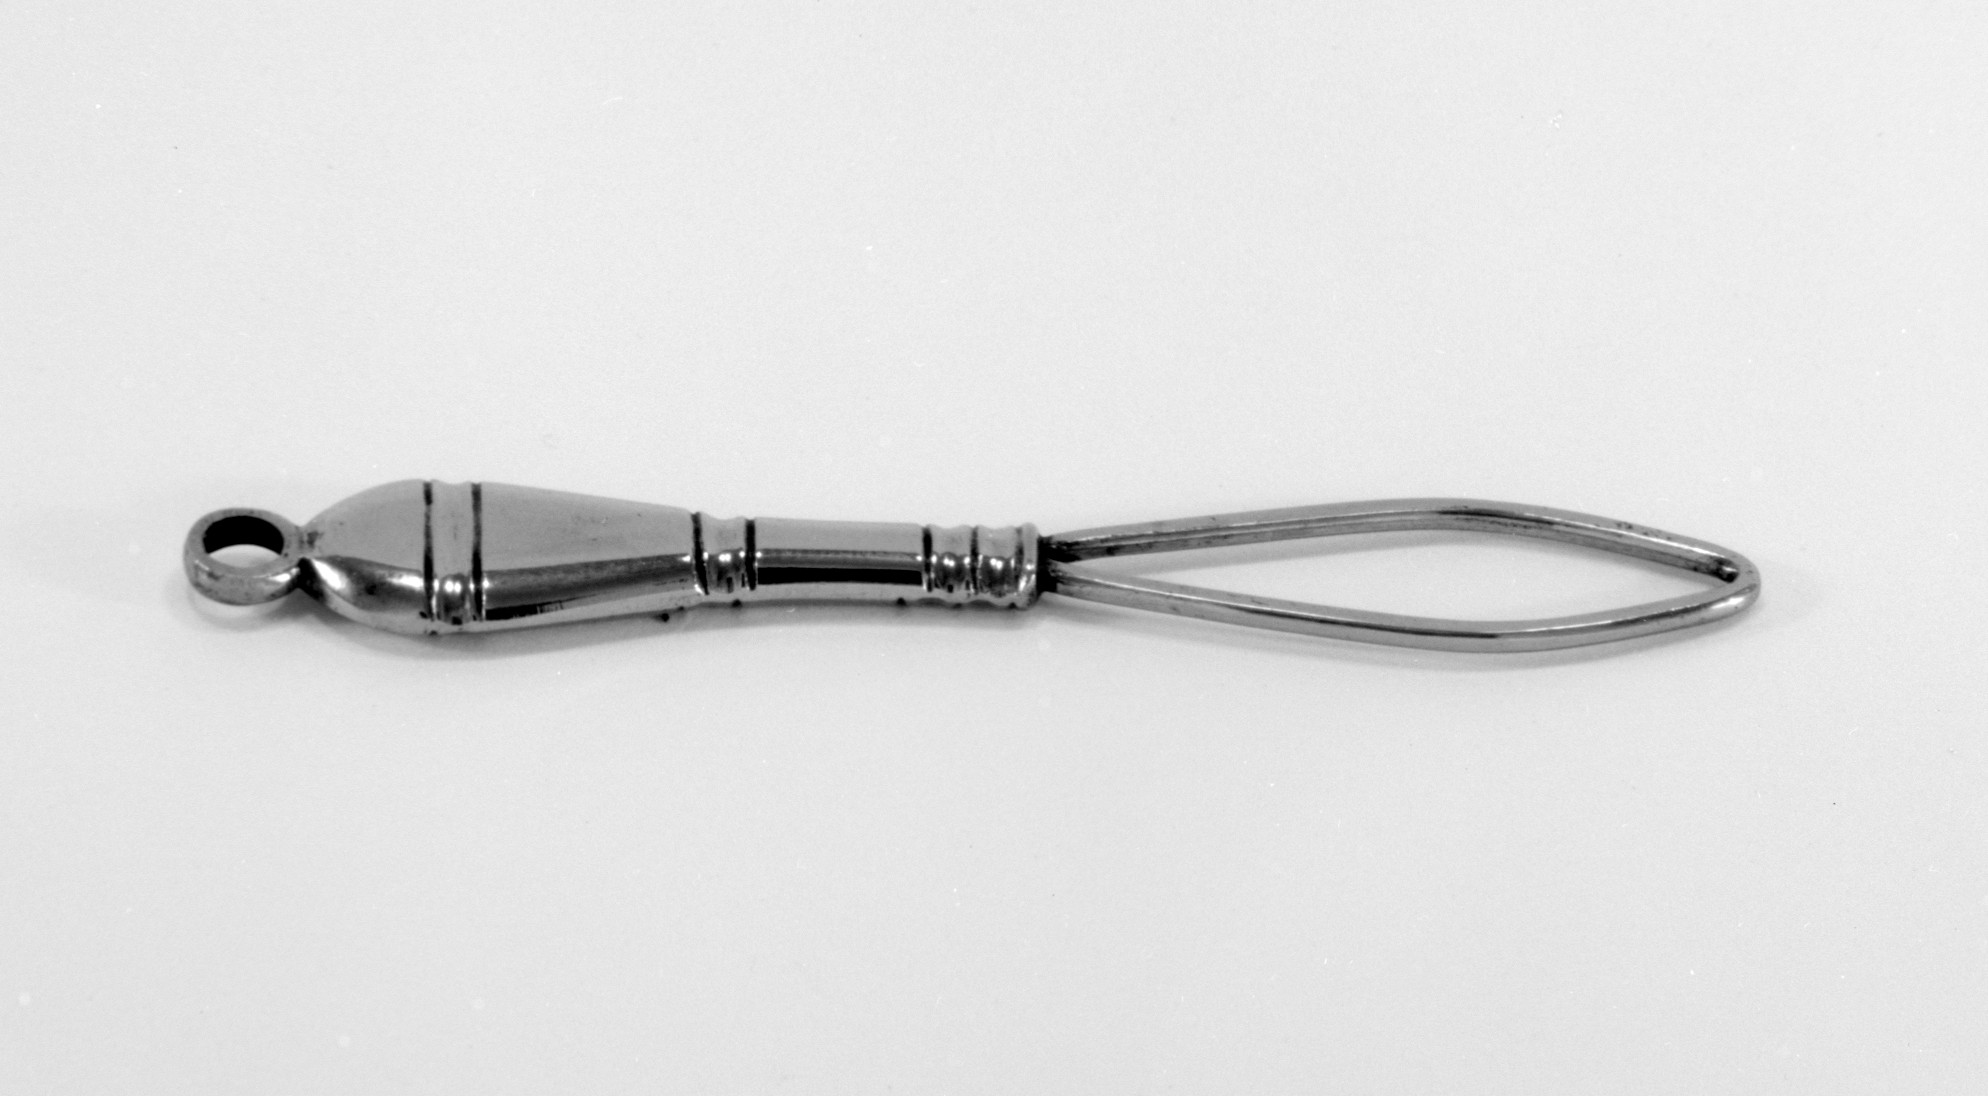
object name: lacer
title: Lacer (?) (part of a set)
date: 1848-1849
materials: steel